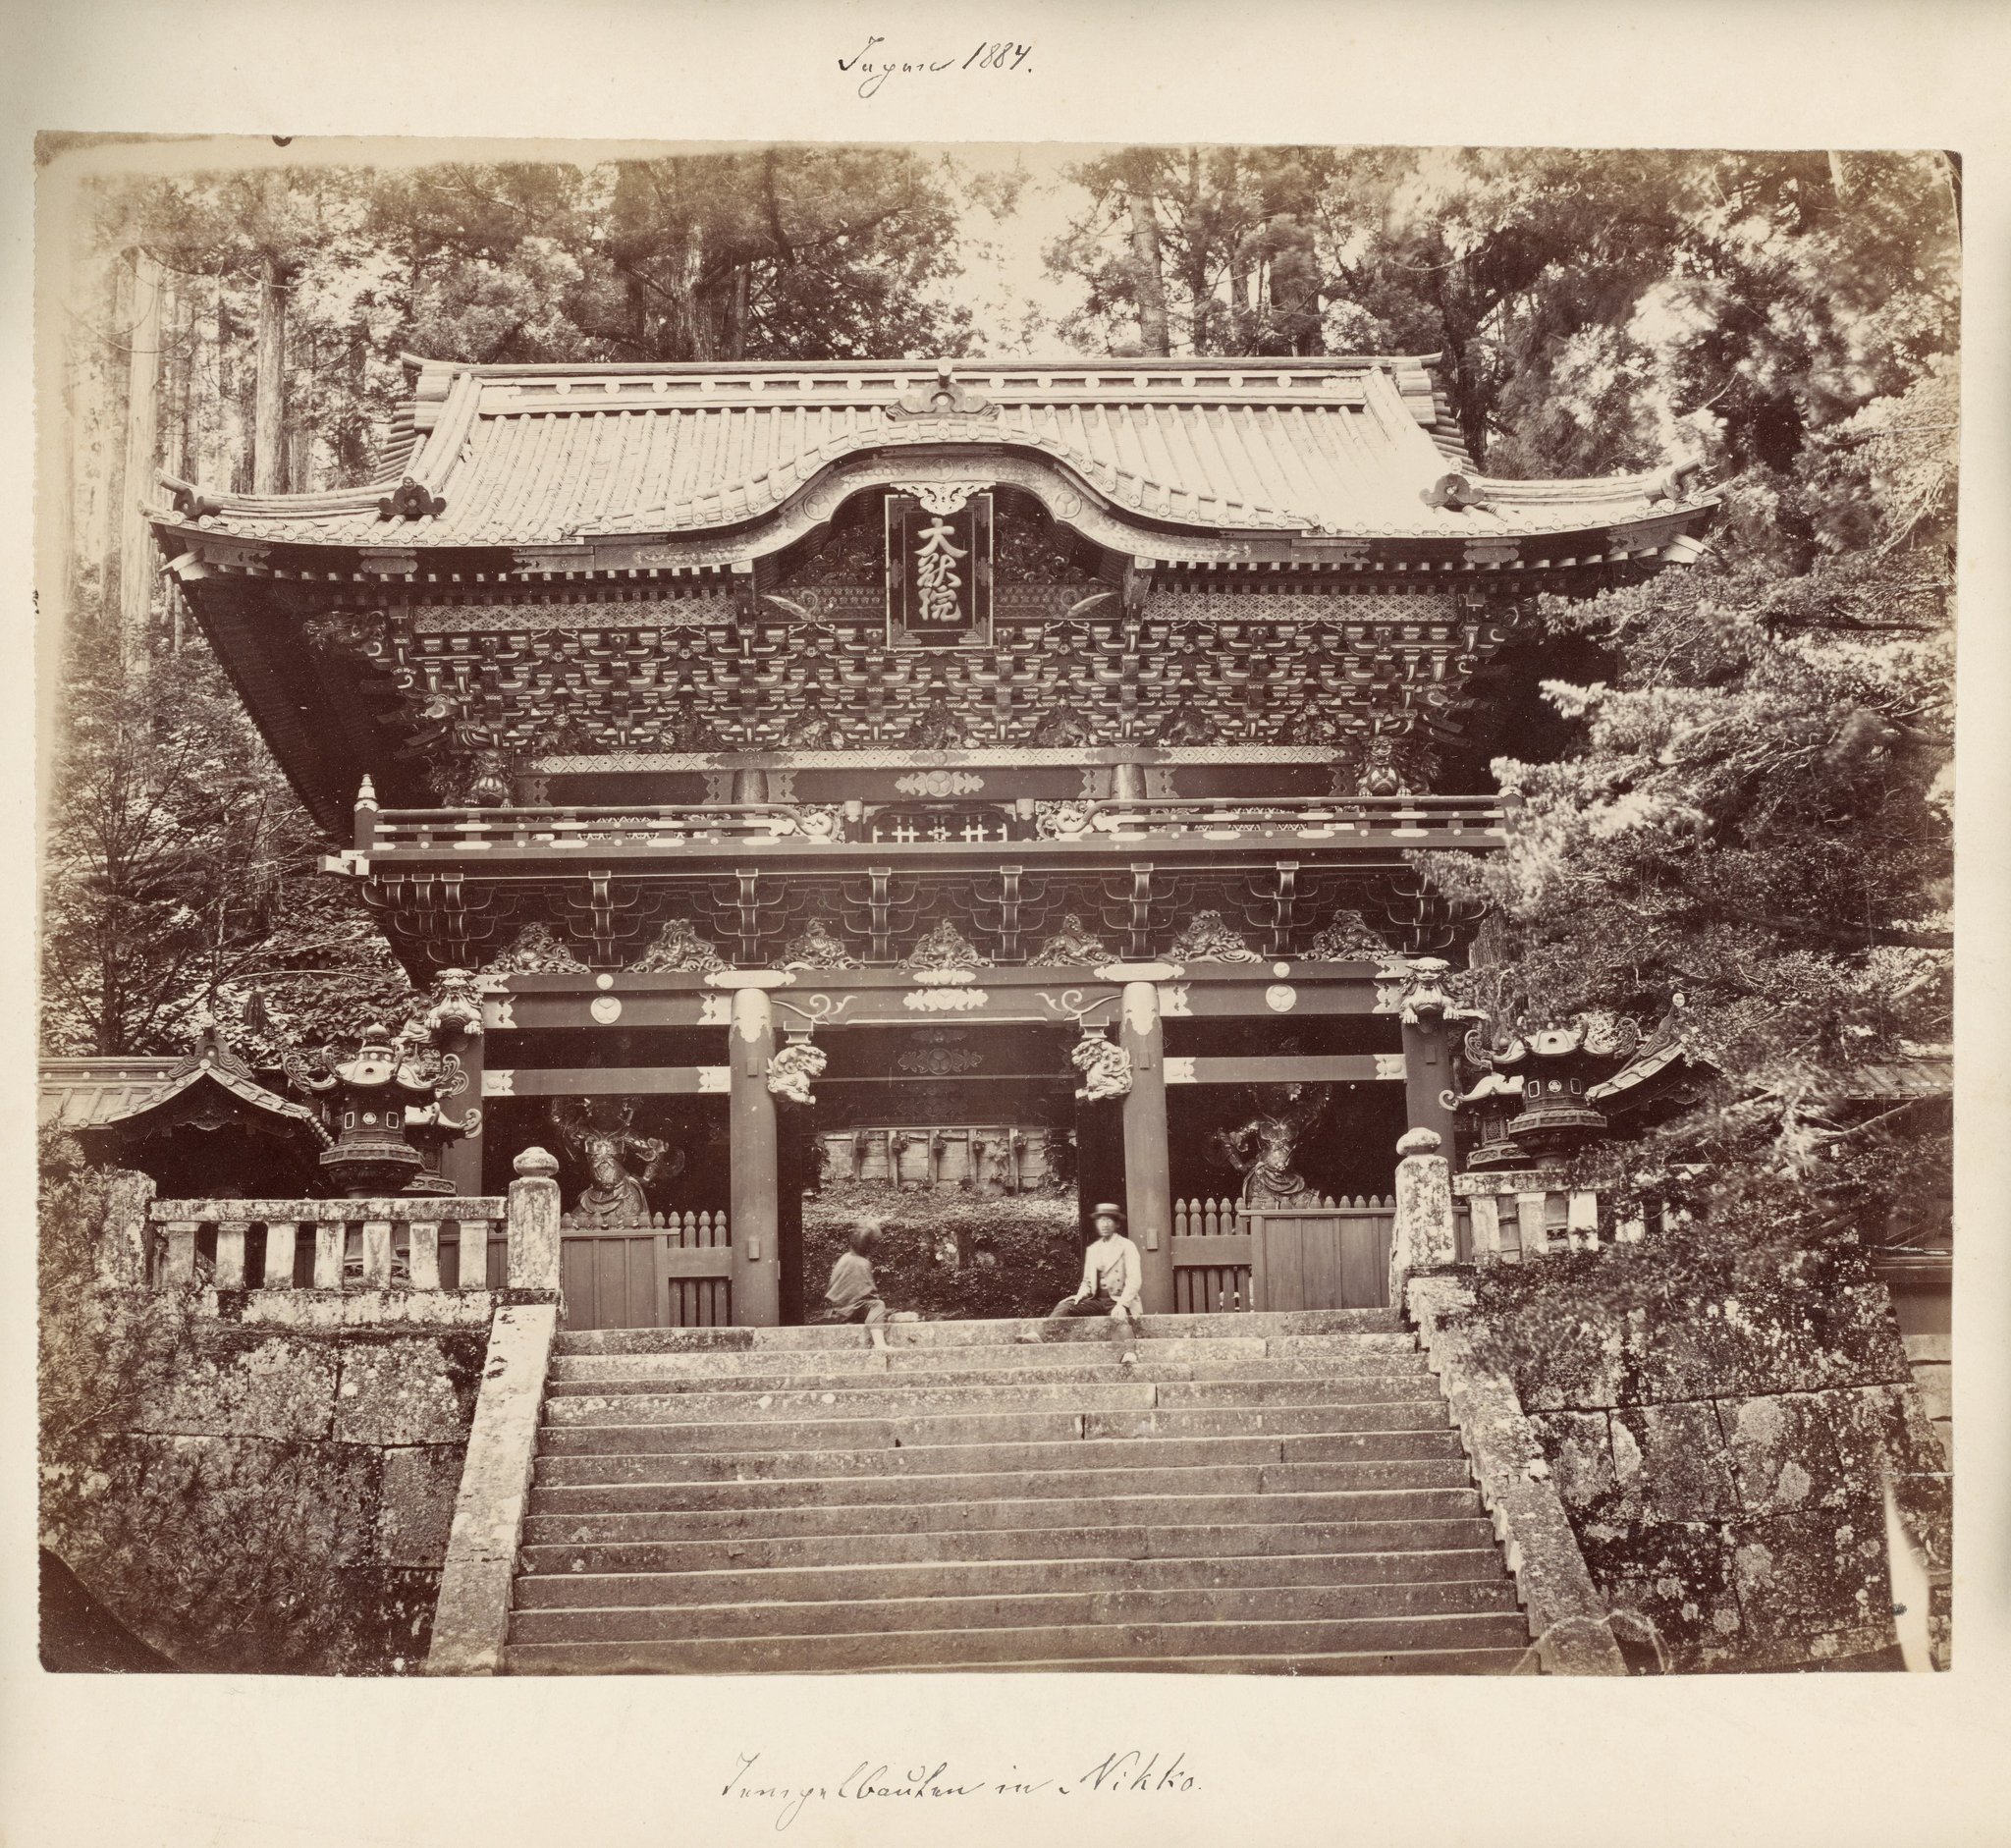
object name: photograph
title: Japan 1884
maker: Anonymous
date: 1884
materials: cardboard, paper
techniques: albumen print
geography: nikkō tōshō-gū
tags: temple, shrine ~ shinto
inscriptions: inscription: ‘Tempelbaüchen in Nikko’